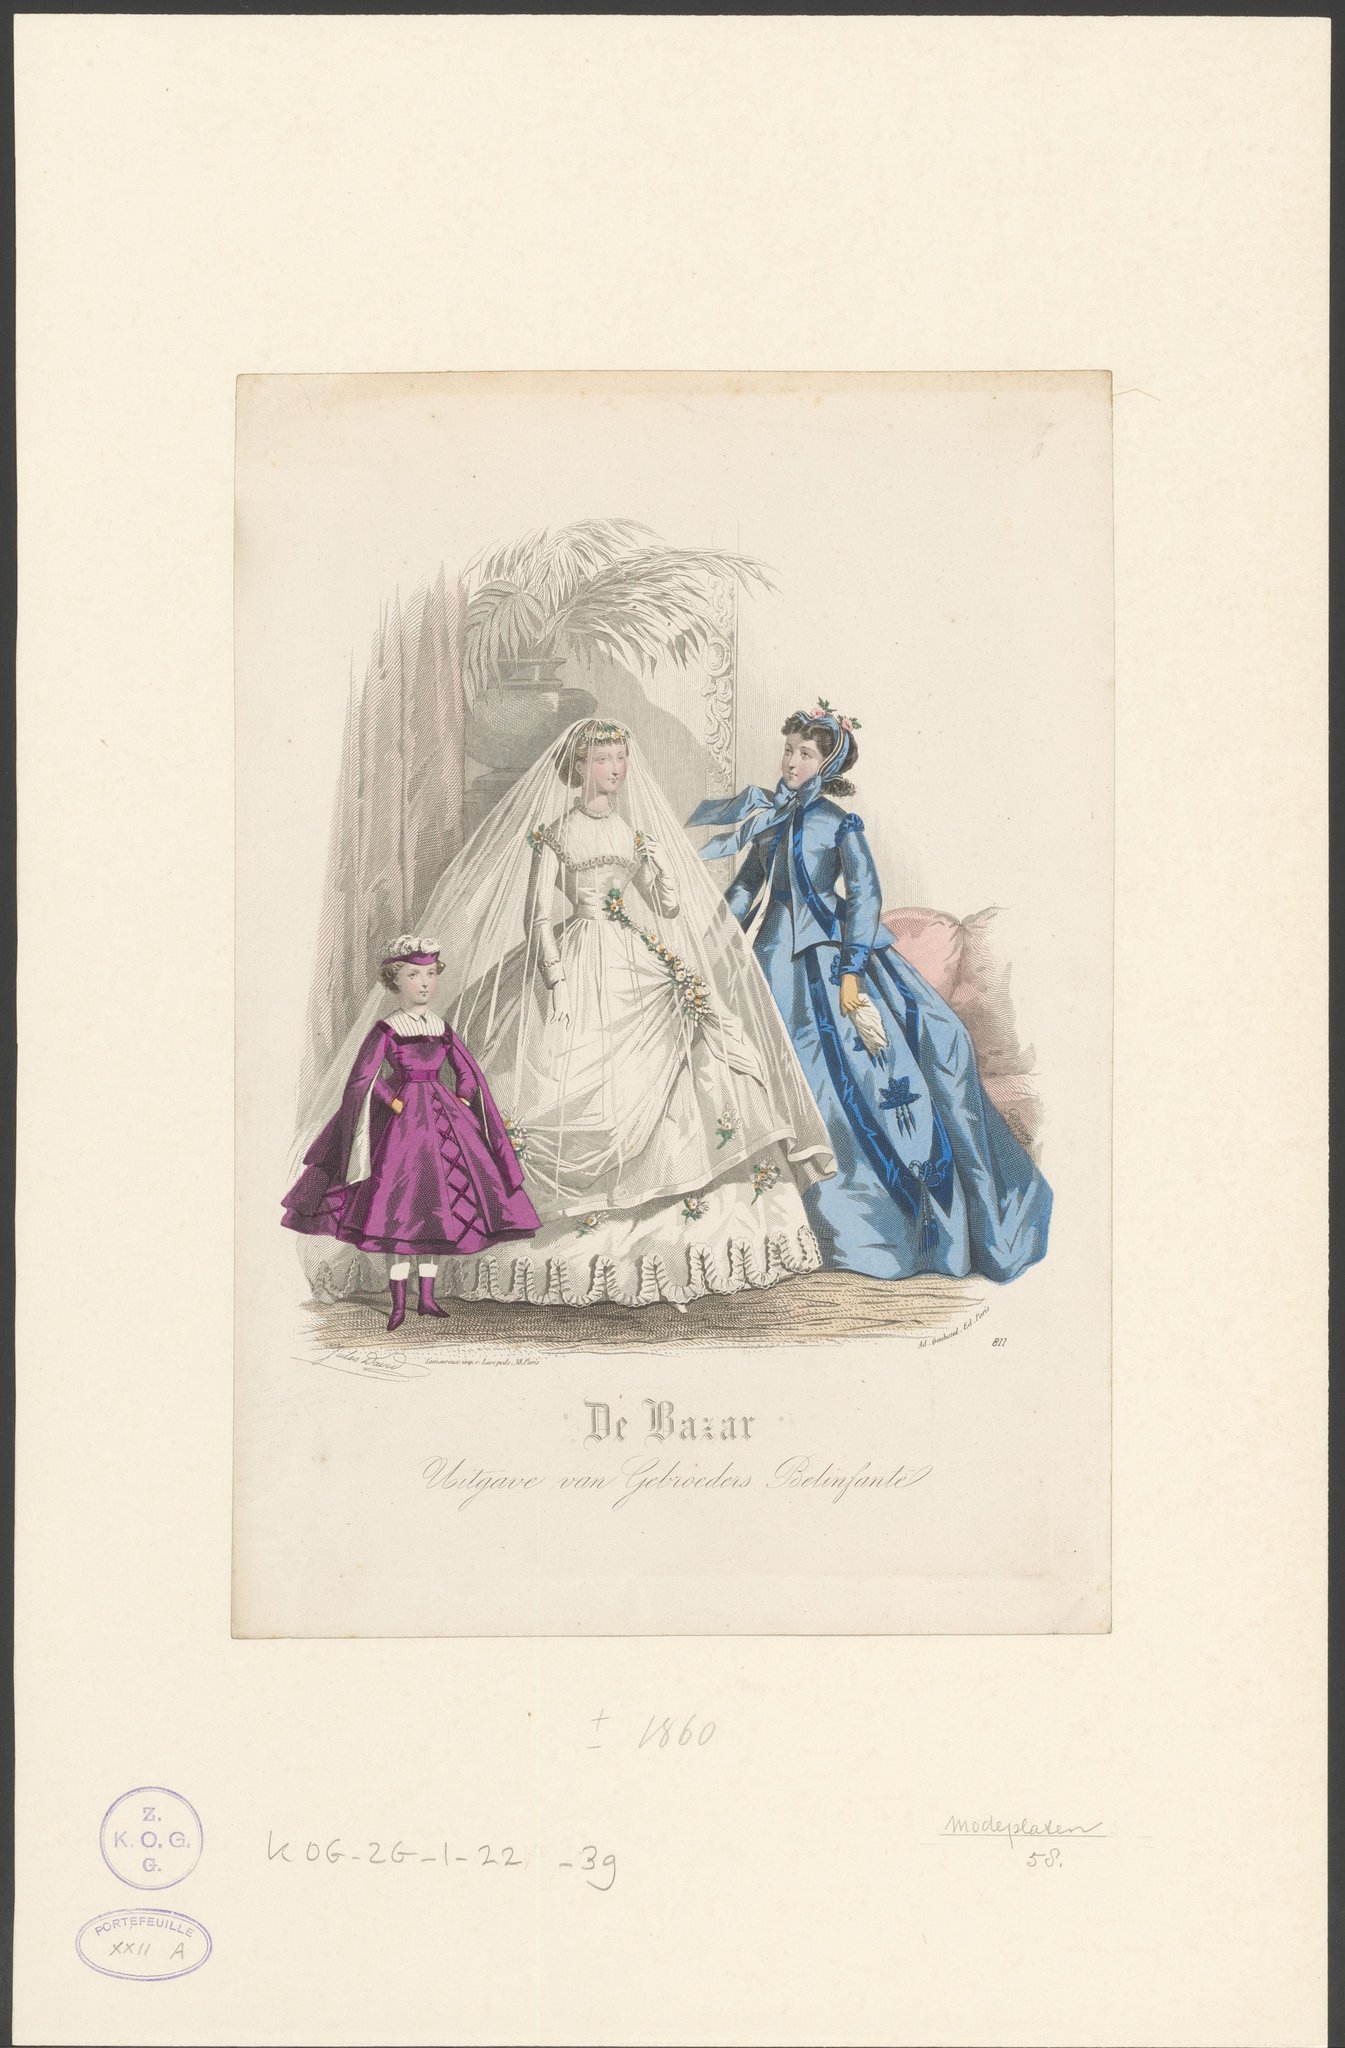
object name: fashion print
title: Bruid met vrouw en meisje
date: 1887-1890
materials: paper, watercolor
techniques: hand coloring, engraving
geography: france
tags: fashion plates, clothes, costume (+ women's clothes), dress, gown (+ women's clothes), bride (in wedding-dress)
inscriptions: collector's mark, collector's mark: Lugt 1641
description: Vrouw in bruidskleding, samen met een andere vrouw en een meisje. Prent uit het modetijdschrift De Bazar, geïllustreerd Tijdschrift voor Modes en Handwerken (1857-1900). Onderwerpsrubrieken binnen de Atlas Zeden en Gewoonten: De Kleeding, Modeplaten.